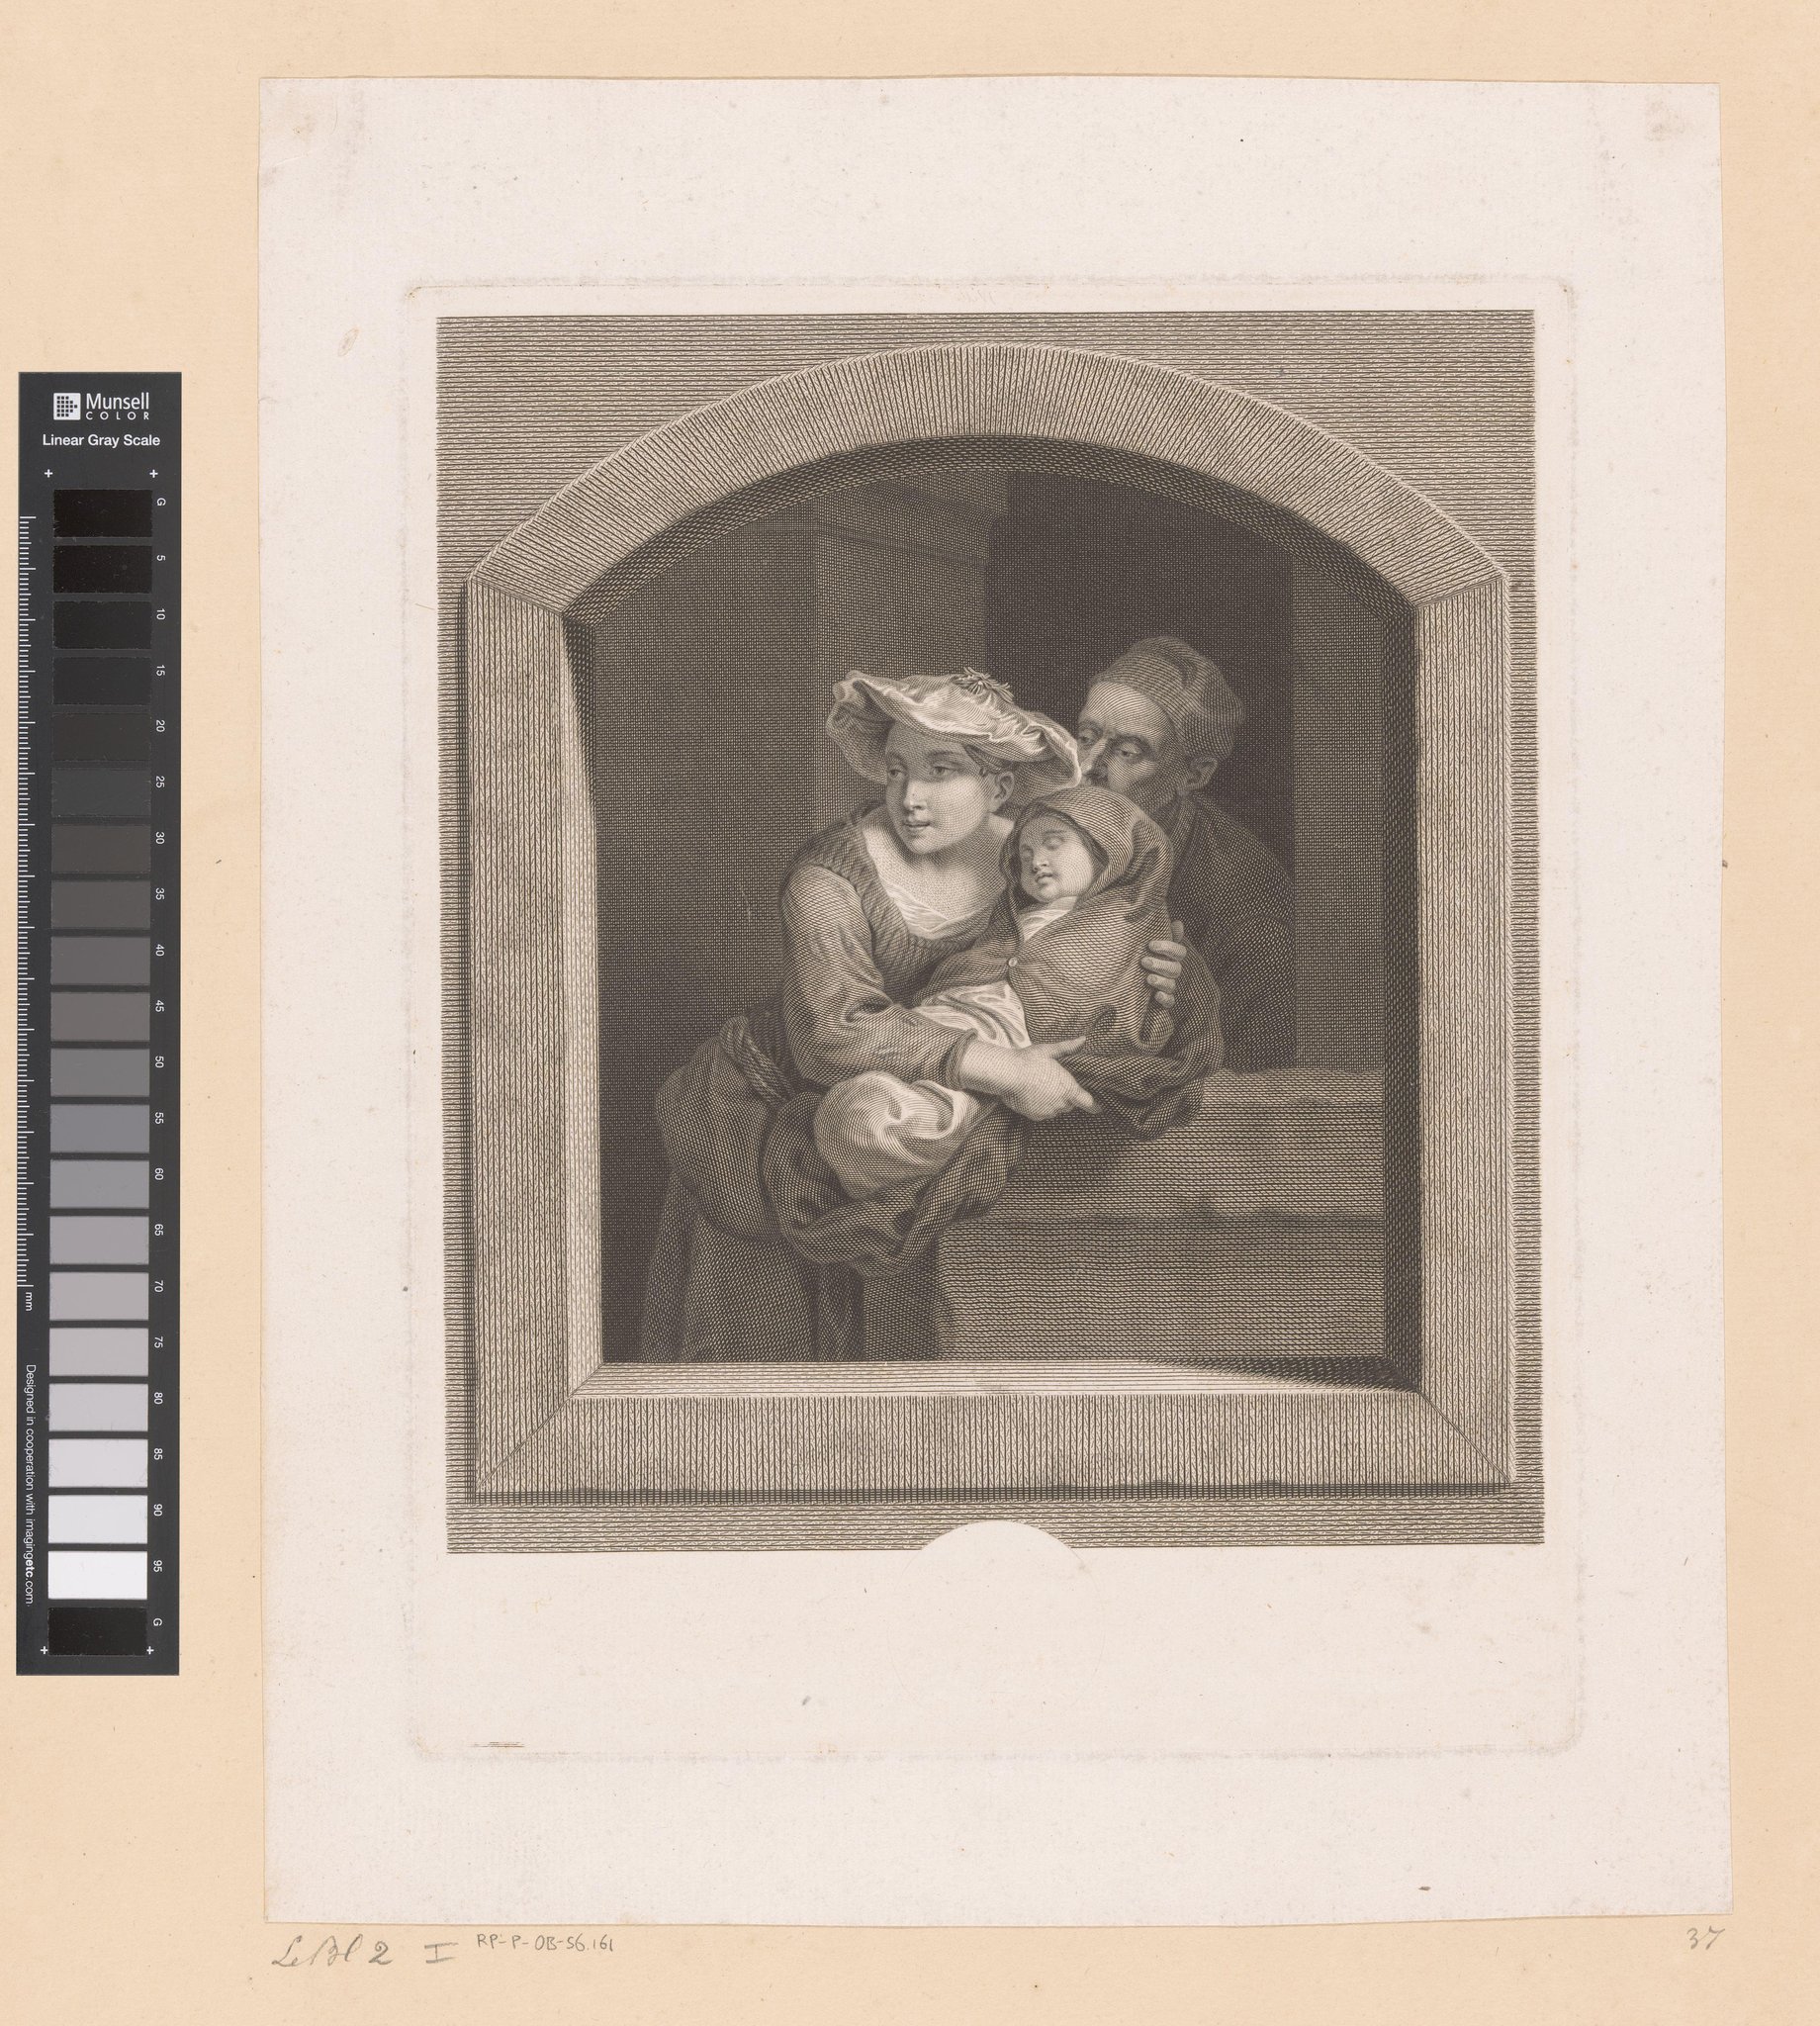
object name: print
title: Repos de la Vierge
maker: johann georg wille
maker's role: draughtsman, print maker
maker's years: 1715-1808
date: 1776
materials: paper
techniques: engraving, etching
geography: paris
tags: holy family, and derived representations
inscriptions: collector's mark: Lugt 240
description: Deze prent maakt deel uit van een serie van onbekende omvang naar Nederlandse en Duitse schilderijen. Op sommige prenten staat linksboven aangegeven welk nummer in de serie het betreft.